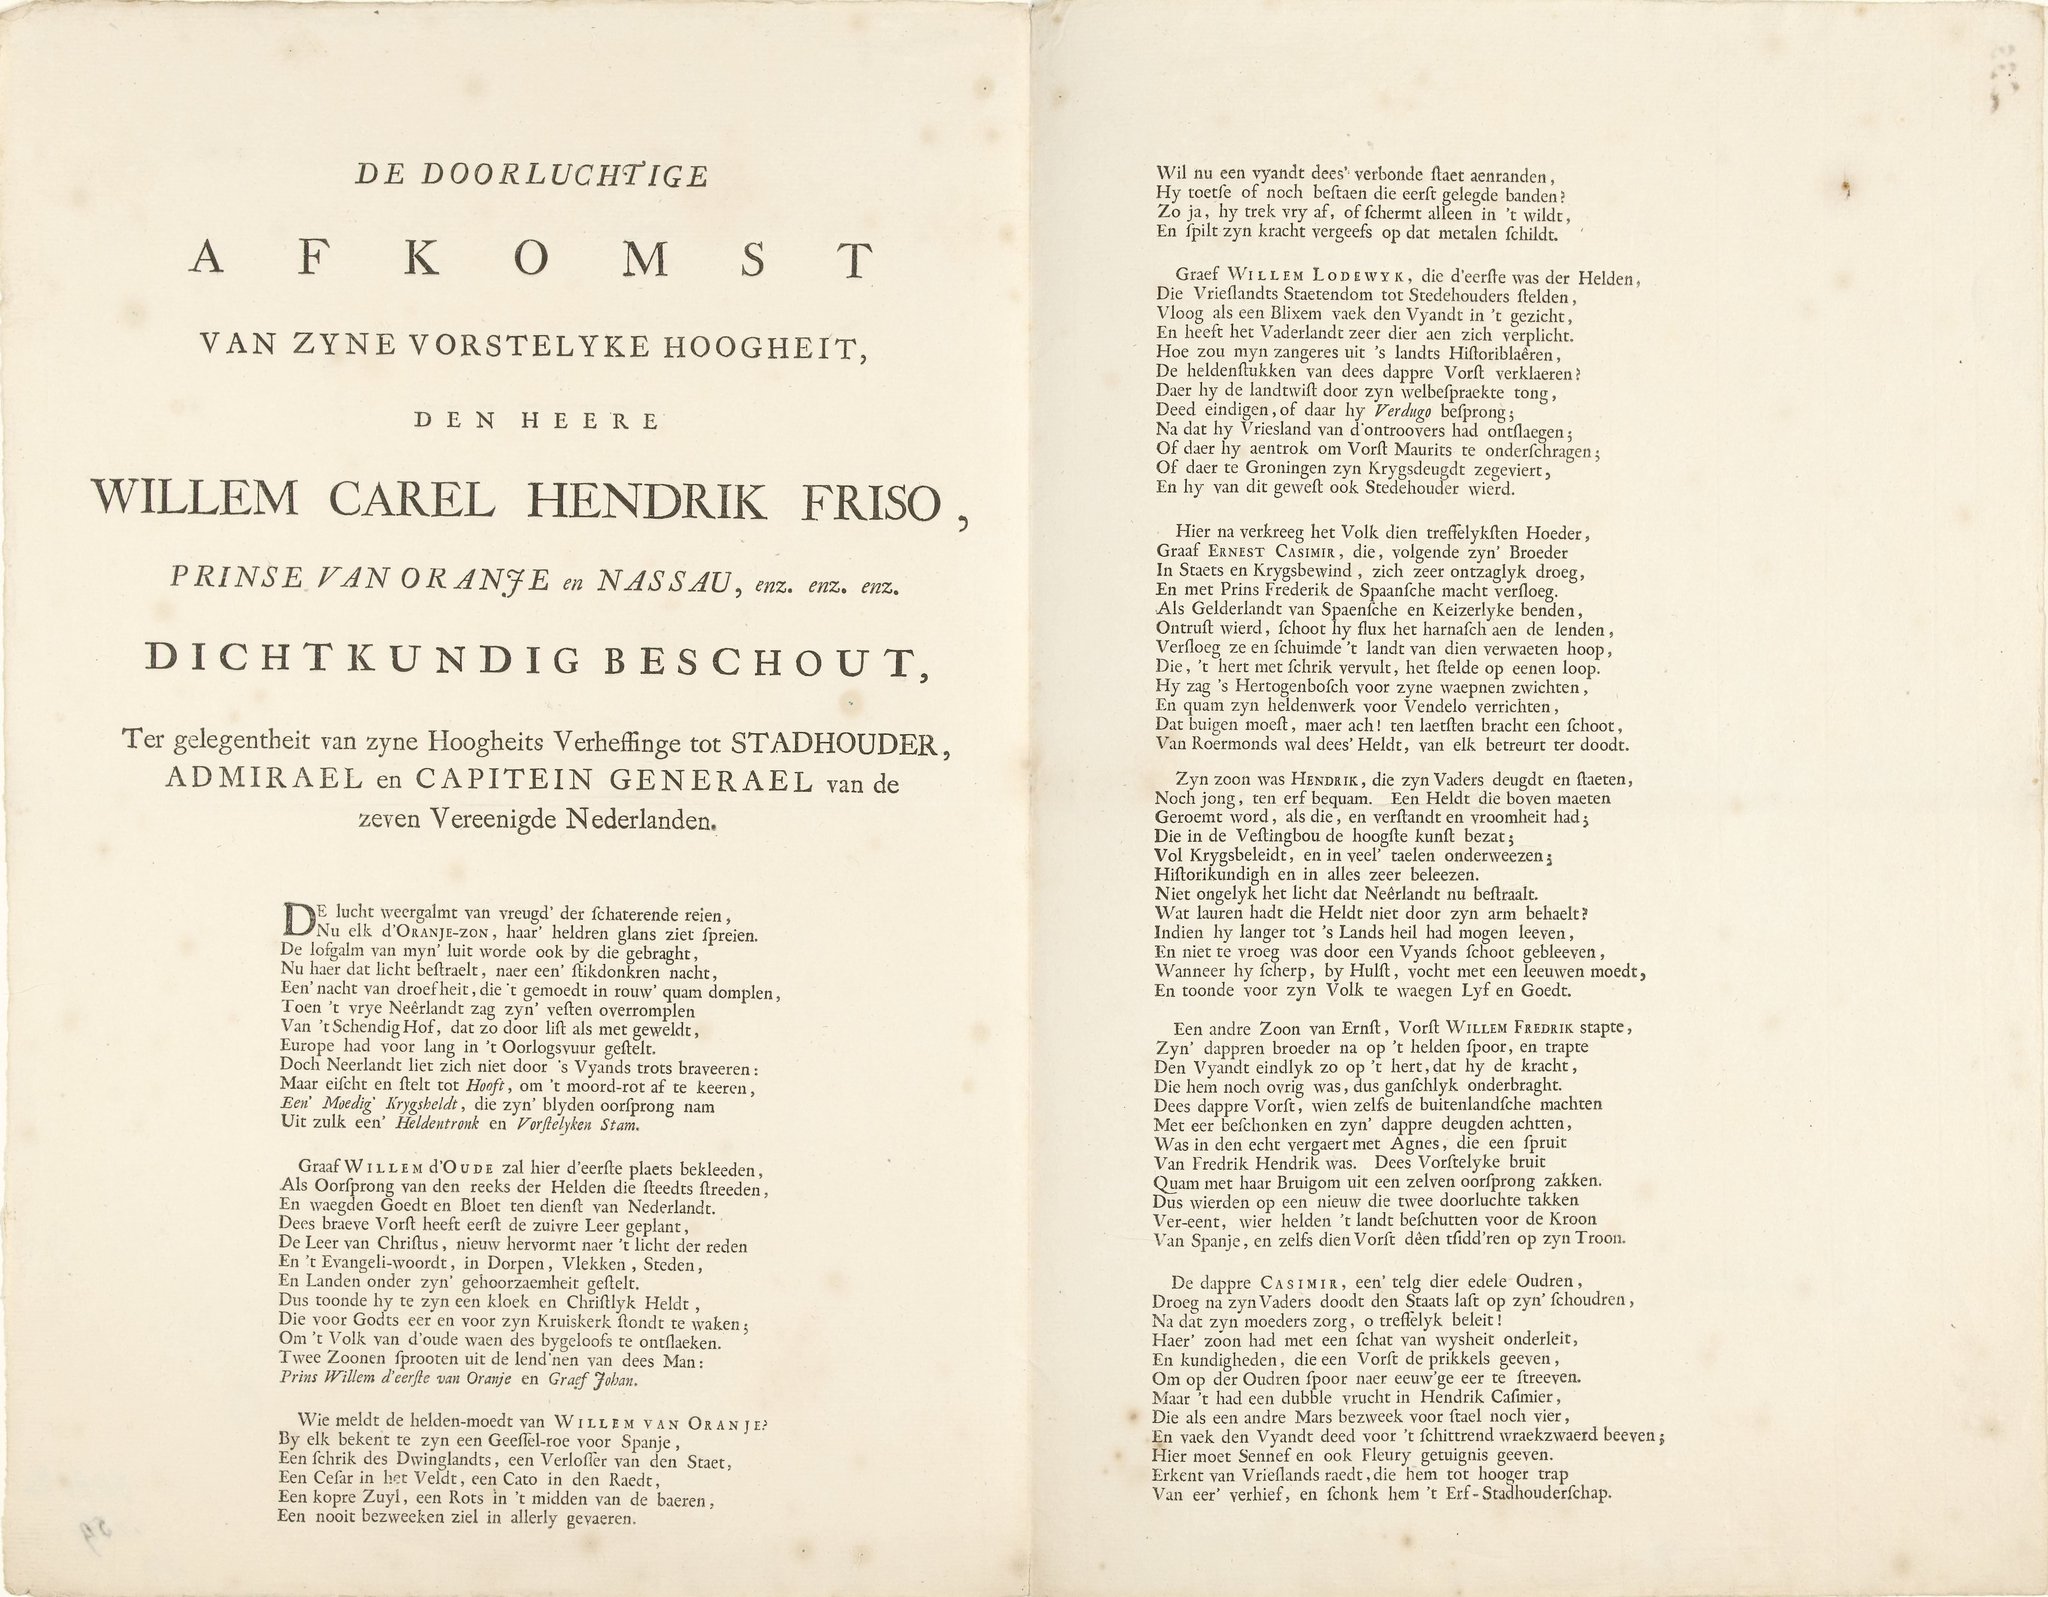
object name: poem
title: Vers op de verkiezing van Willem IV tot stadhouder (blad 1), 1747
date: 1747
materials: paper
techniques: letterpress printing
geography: amsterdam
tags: the hague, willem iv (prins van oranje-nassau)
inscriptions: collector's mark: Lugt 2228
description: Vers op de vorstelijke afkomst van de prins en de verkiezing van Willem IV tot erfstadhouder, mei 1747. Dubbelgevouwen blad op twee bladzijden bedrukt met verzen. Eerste van twee bladen.